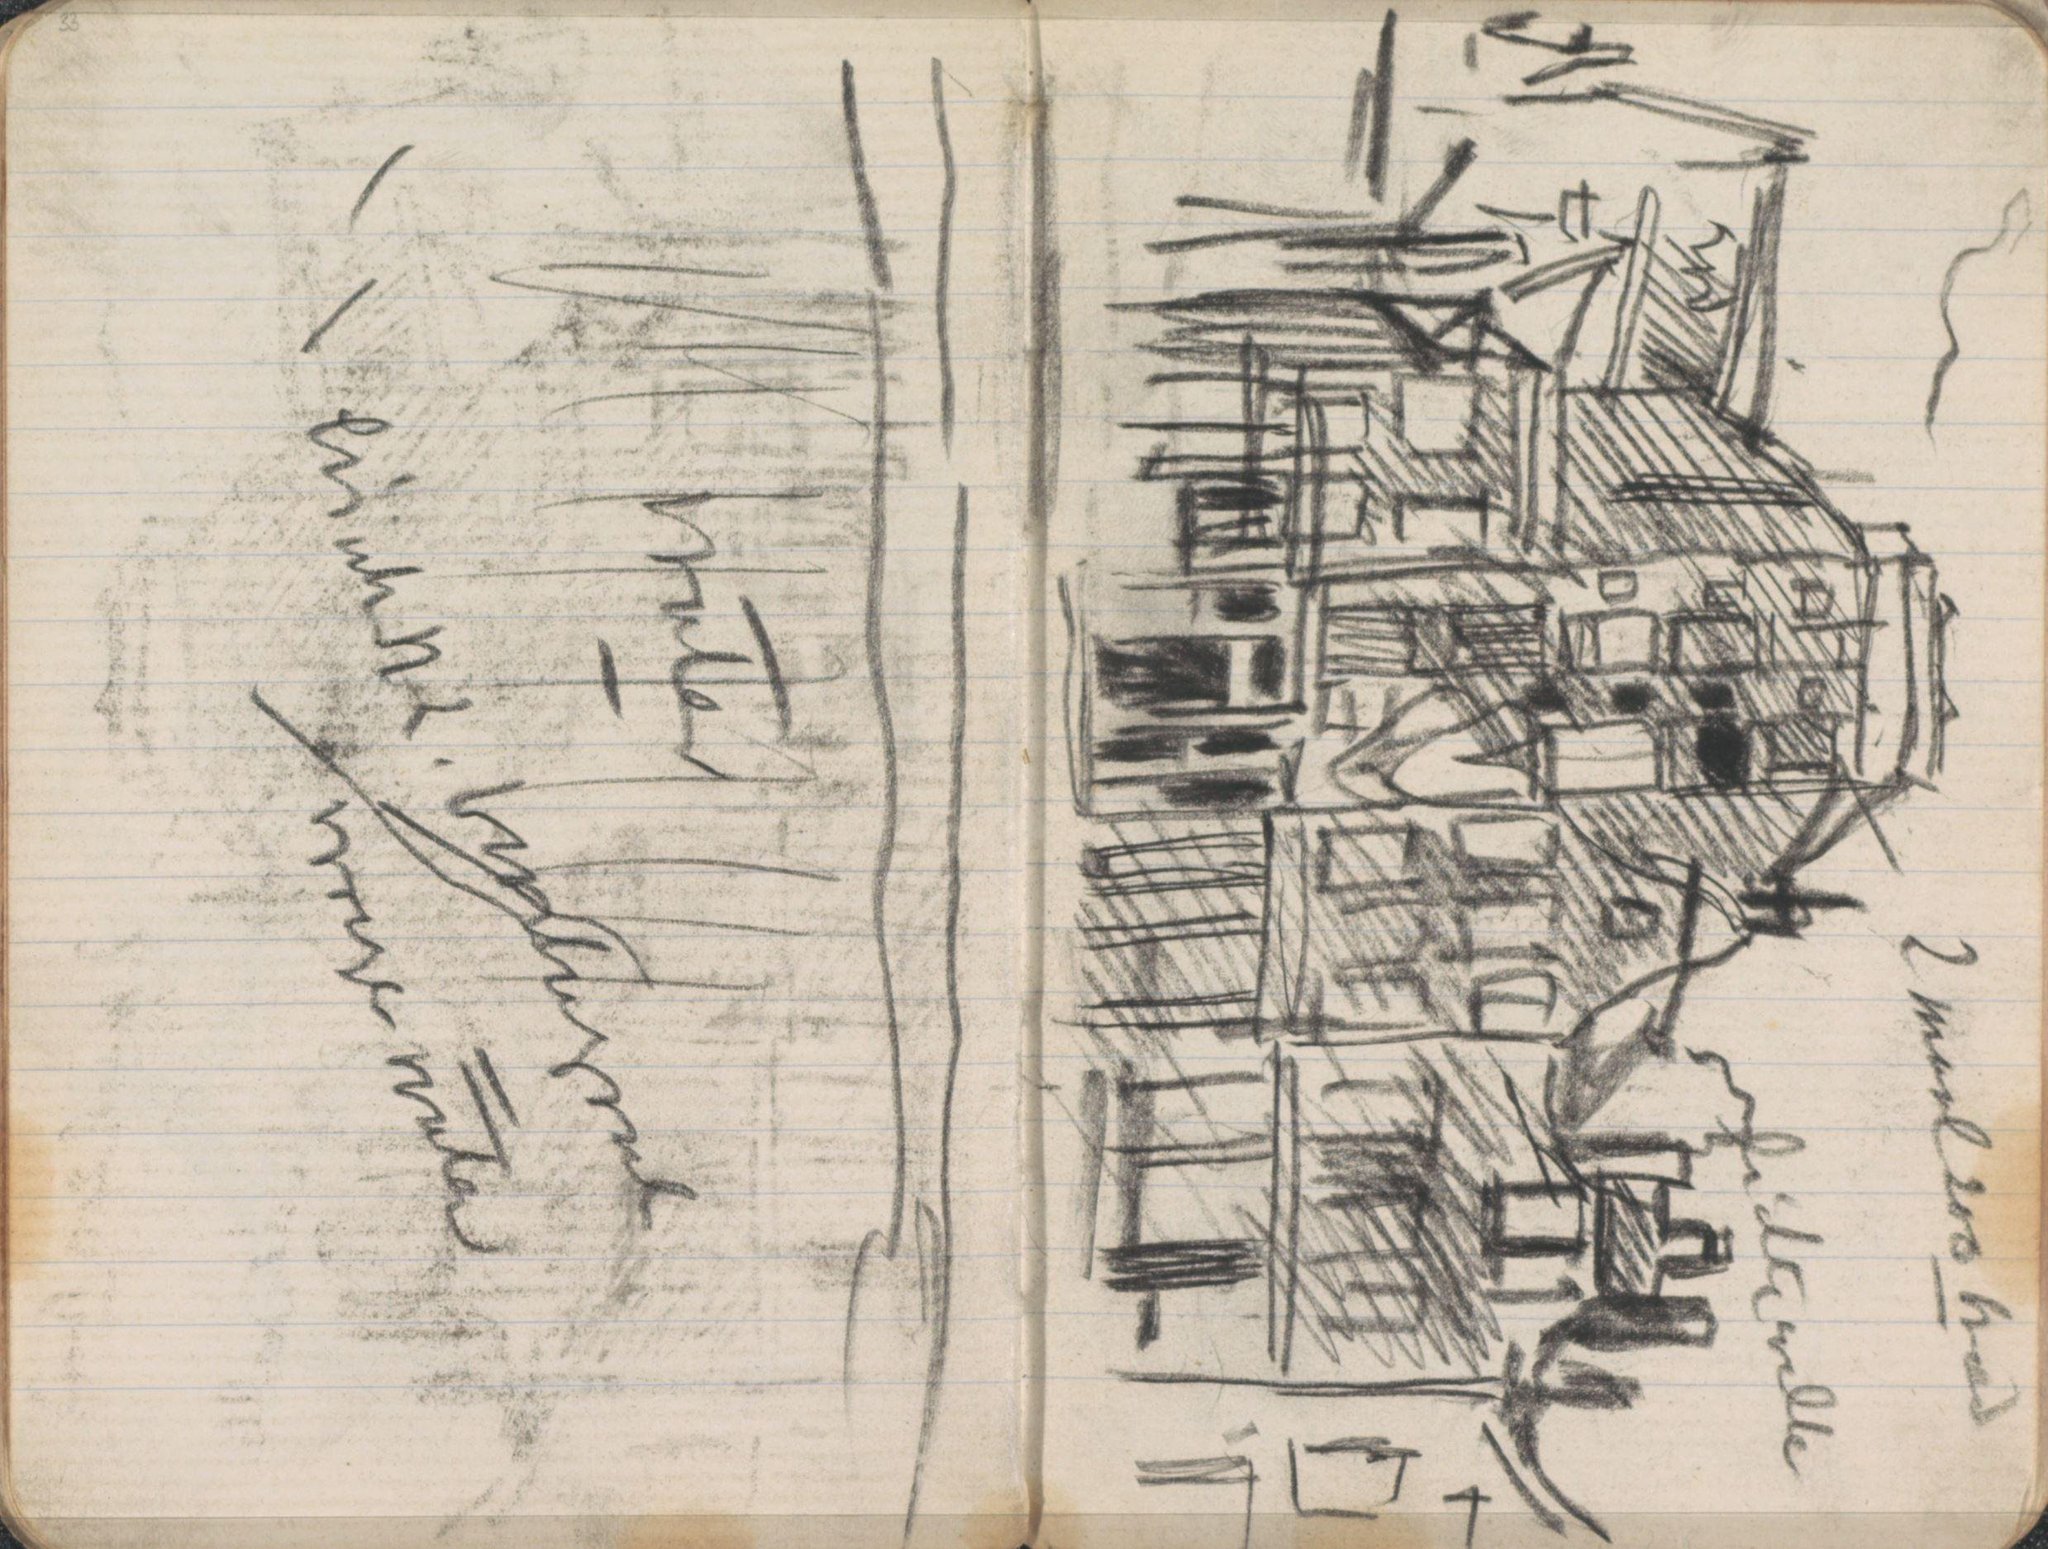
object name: sketchbook leaf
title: Gezicht op de Nieuwezijds Voorburgwal in Amsterdam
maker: george hendrik breitner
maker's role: draughtsman, painter, print maker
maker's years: 1857-1923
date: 1896-1901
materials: chalk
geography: amsterdam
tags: civic architecture; edifices; dwellings, street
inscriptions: annotation: ‘2 maal 200 breed/ [...]/ water/ [...] NZ. Voorburgwal/ vroeger water’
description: Pagina 33 en pagina 34 uit een schetsboek met 37 bladen.